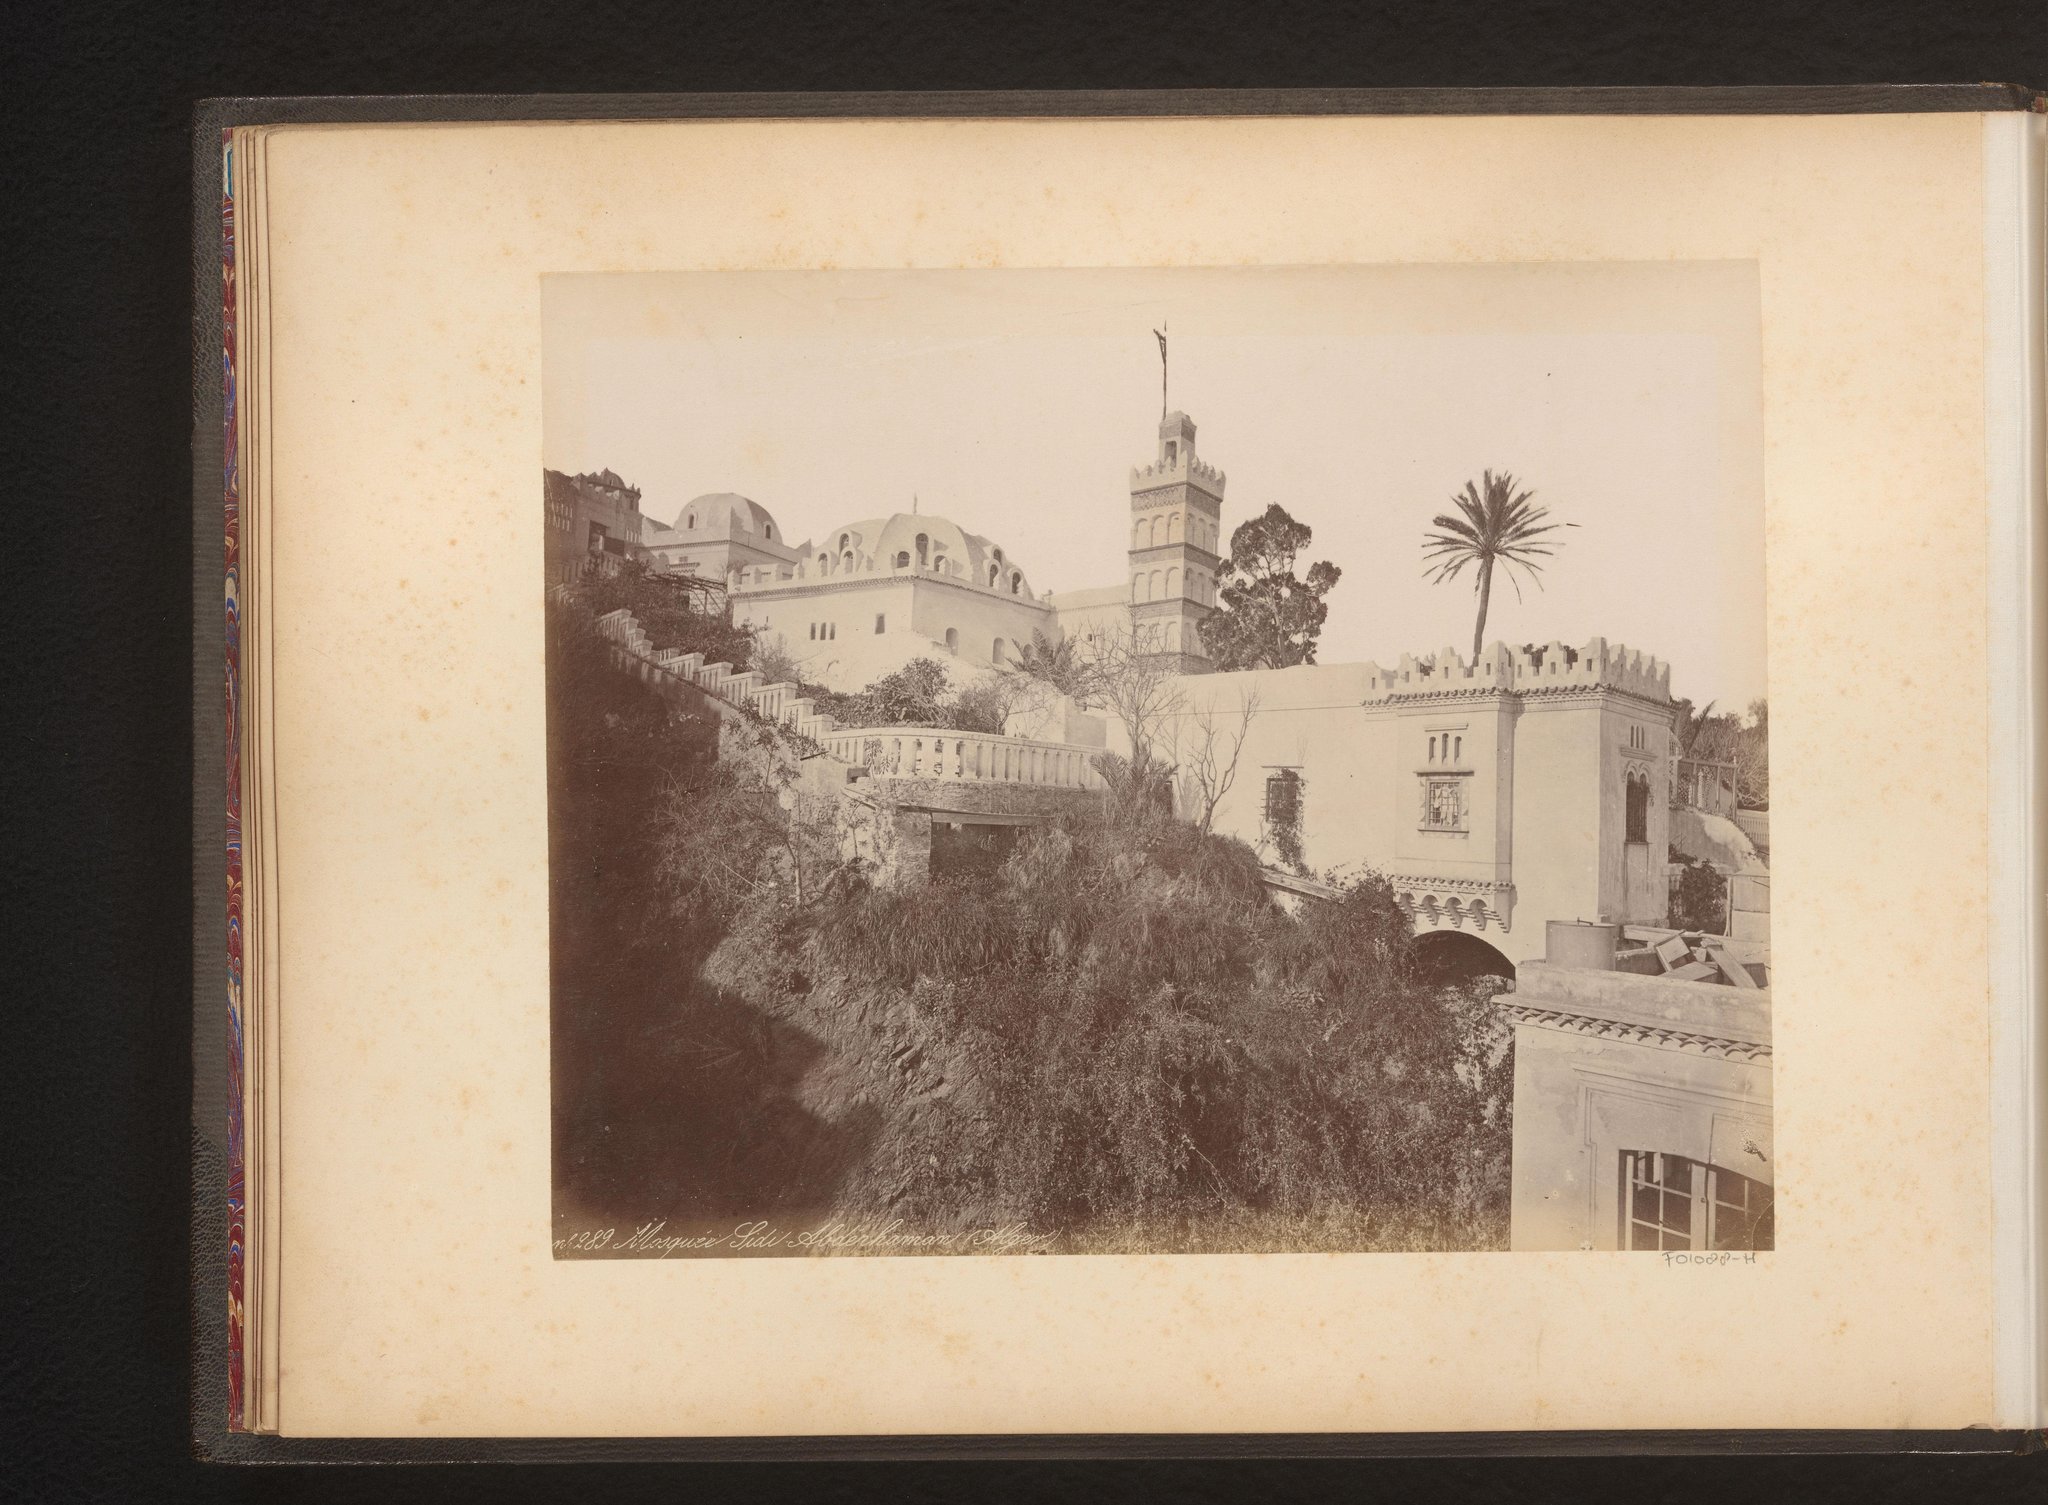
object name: album leaf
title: Mosquee Sadi Abdenhaman (Alger)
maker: Anonymous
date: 1880-1890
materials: photographic support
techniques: albumen print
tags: temple, shrine ~ islam, mohammedanism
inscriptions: number: ‘289’